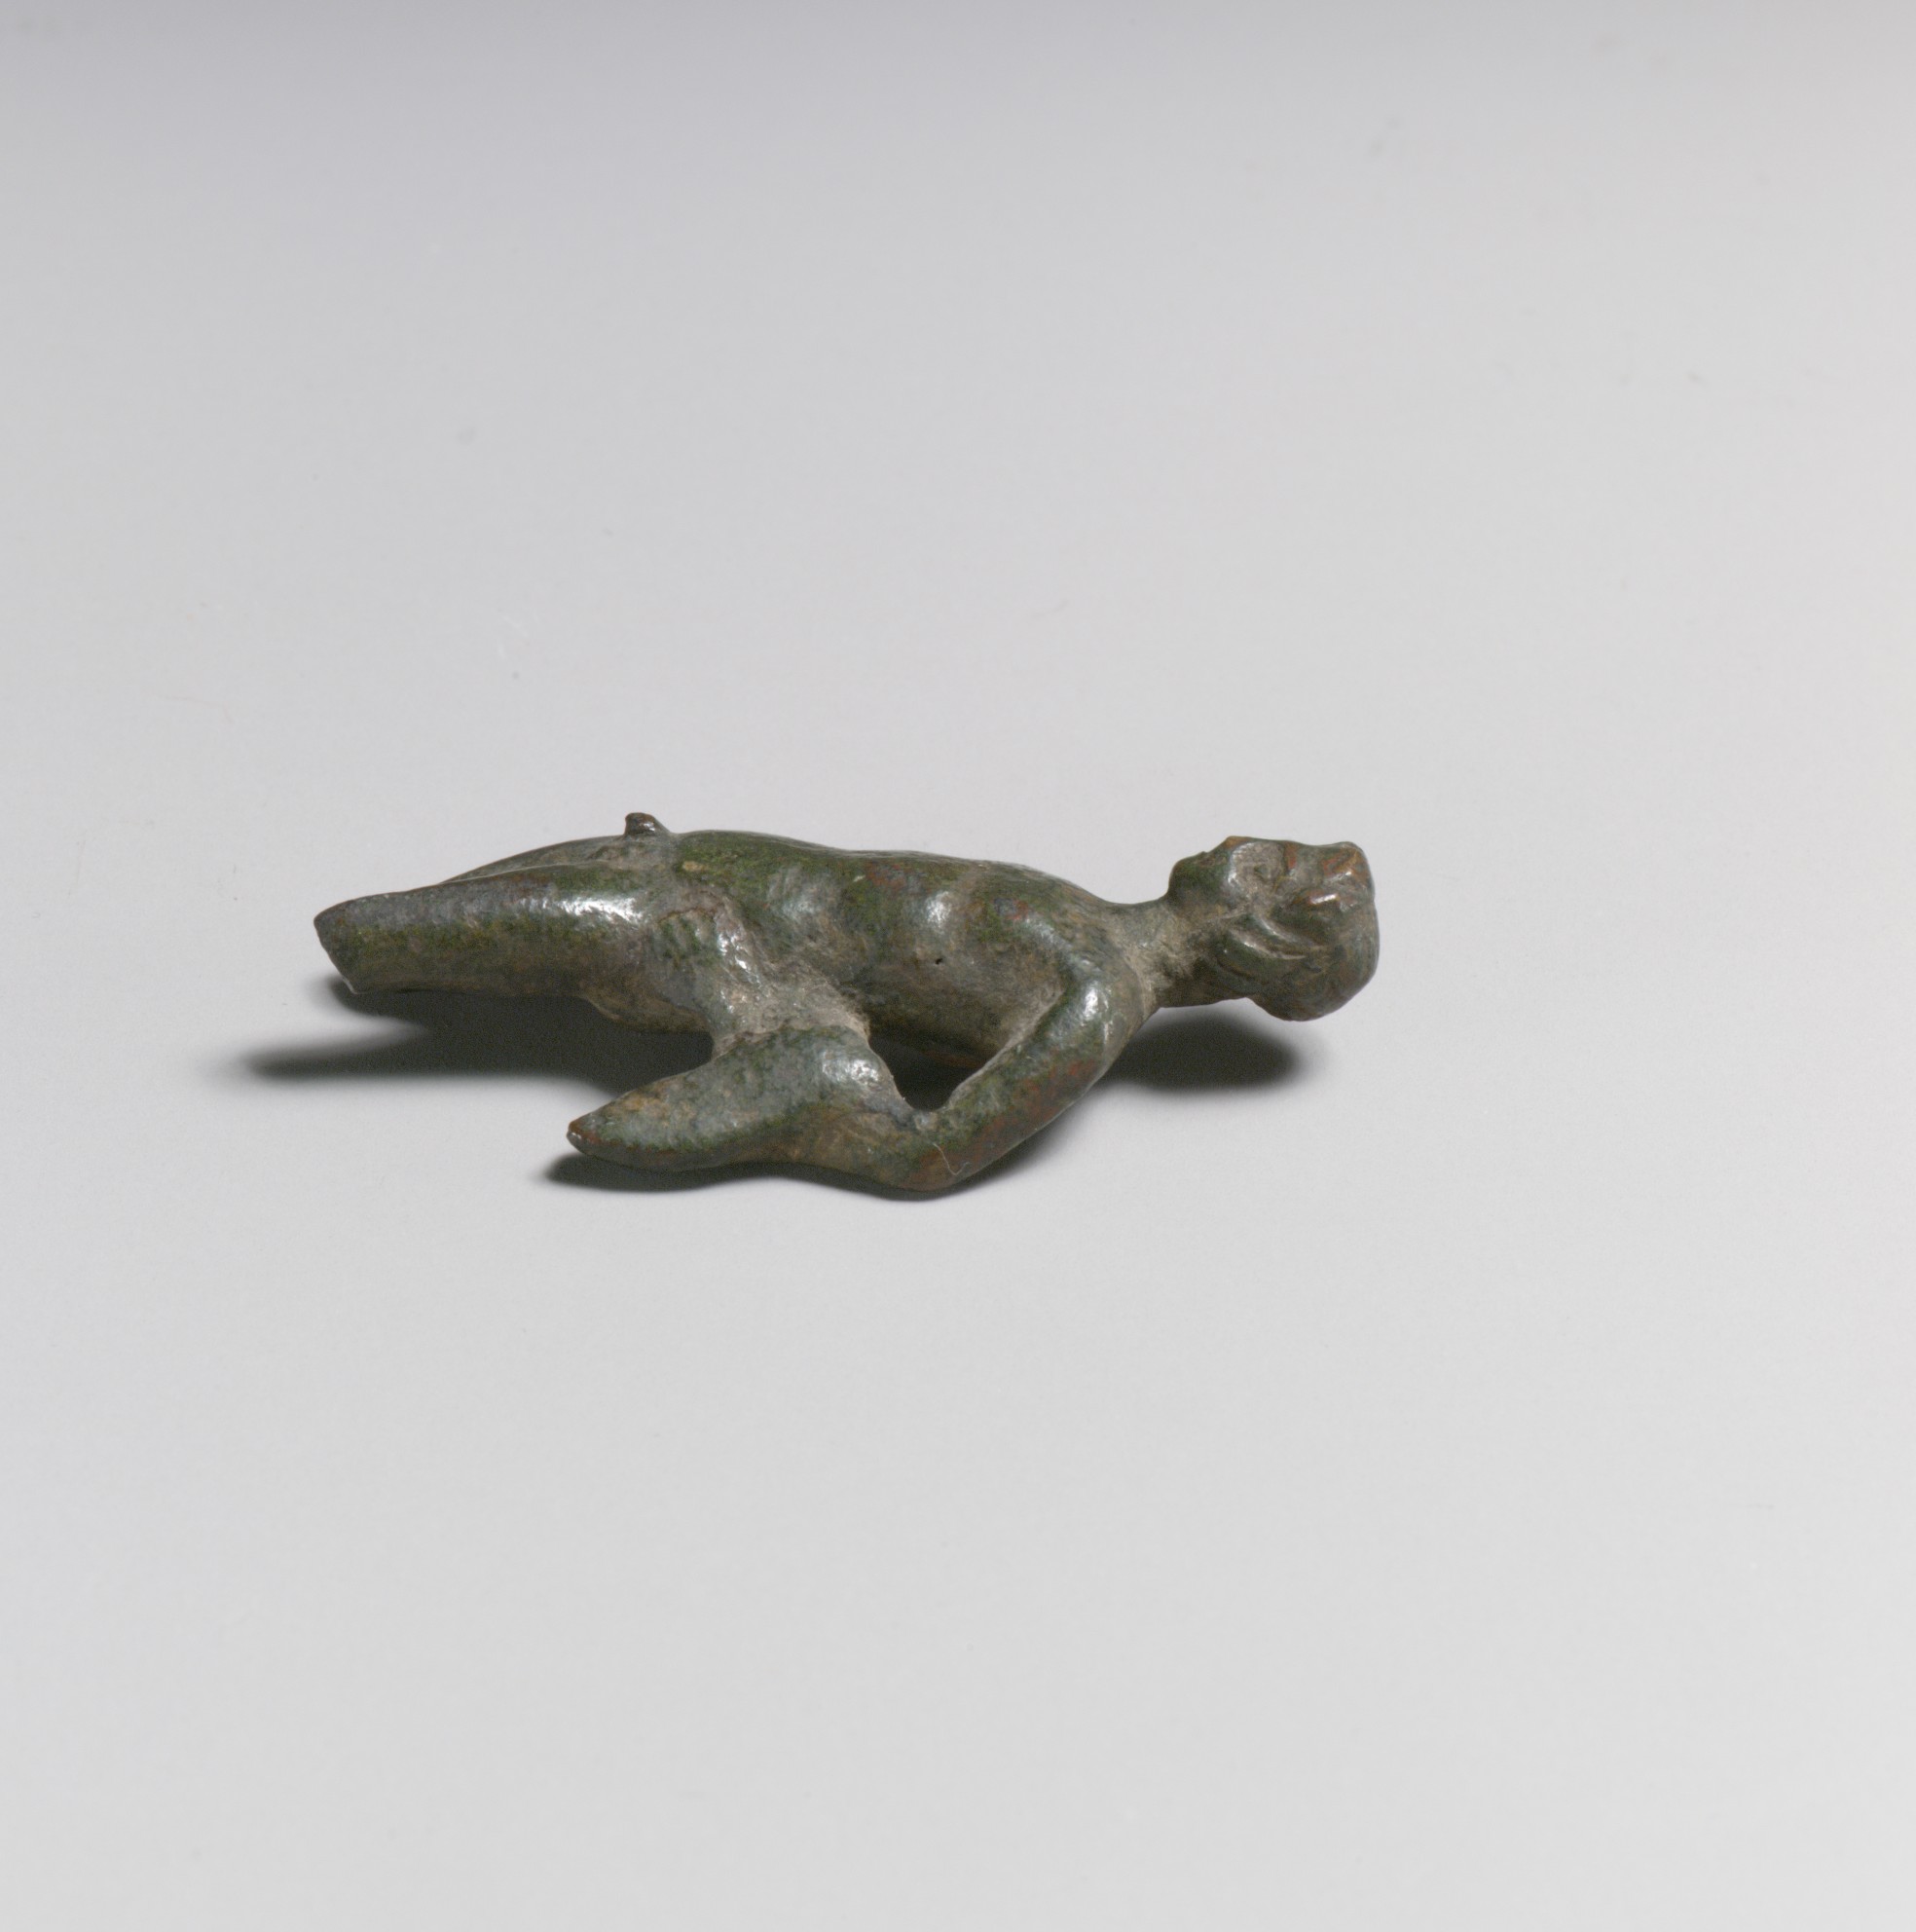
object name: statuette of a youth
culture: roman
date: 1-200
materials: bronze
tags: men